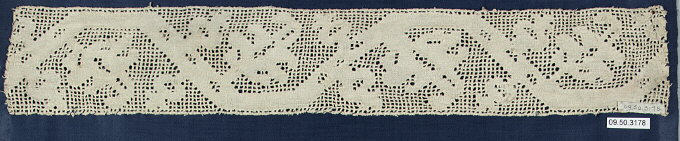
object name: border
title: Border fragment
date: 1501-1700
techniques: embroidery